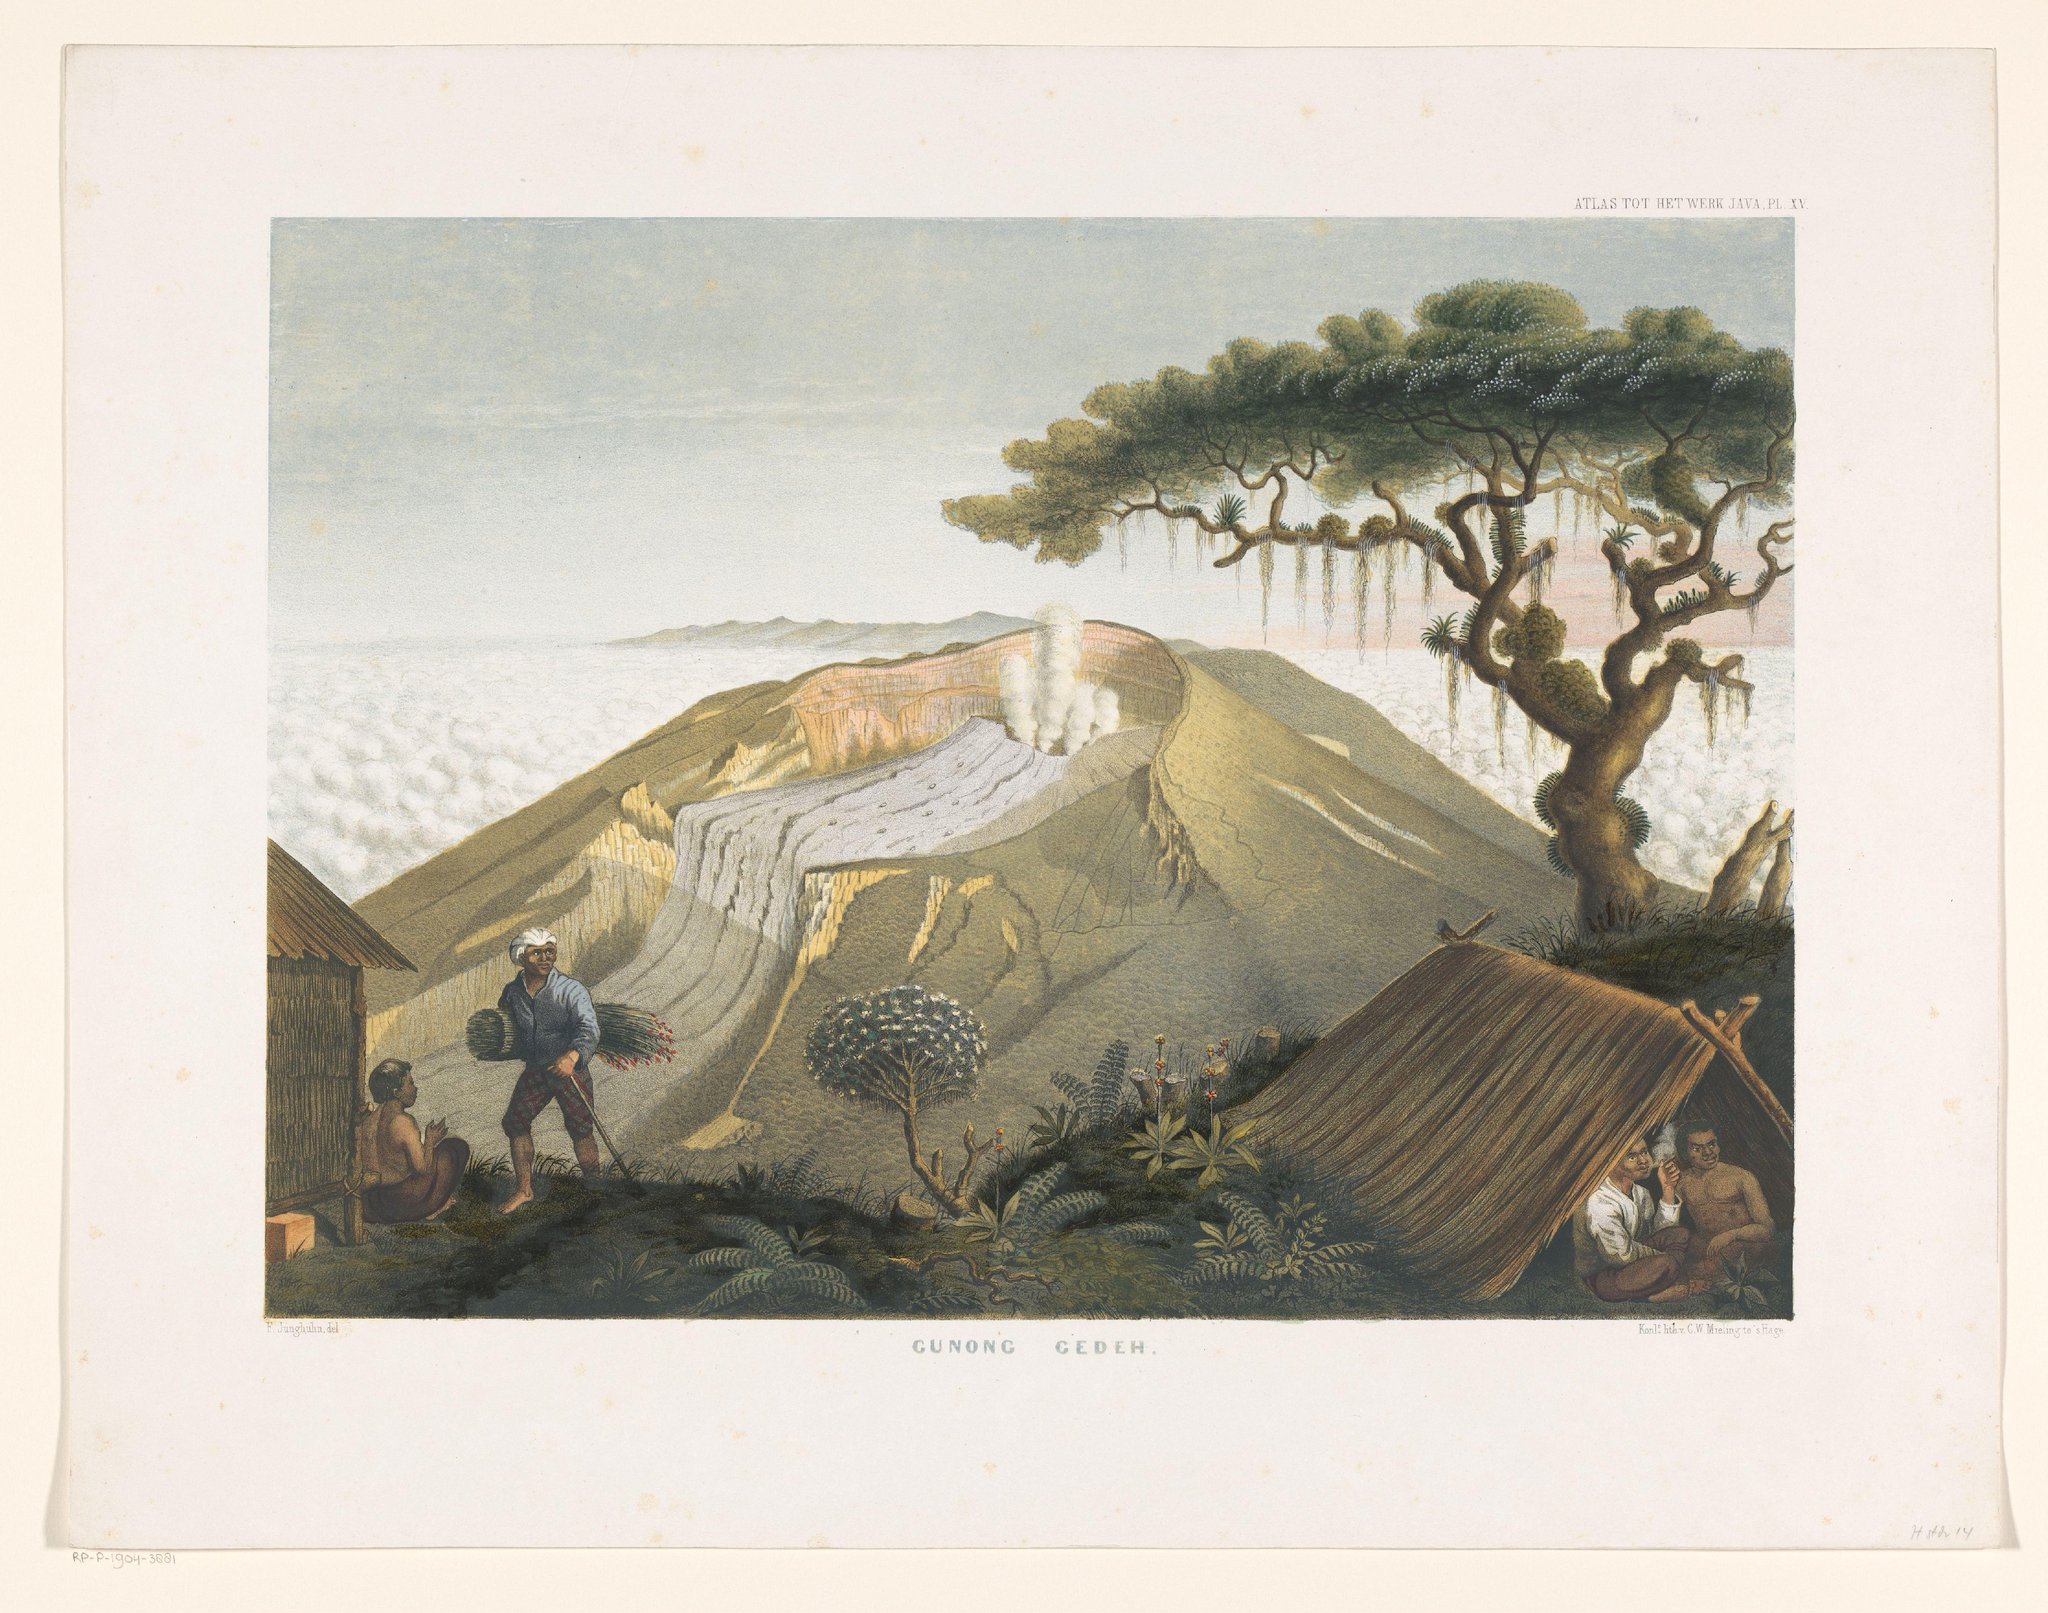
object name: print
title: Vulkaan Gede te West-Java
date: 1854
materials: paper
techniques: lithograph, hand coloring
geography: the hague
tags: volcano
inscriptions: collector's mark: Lugt 2228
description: Onderdeel van een serie van elf, bedoeld als aanvulling op: Junghuhn, Franz. Java: zijne gedaante, zijn plantentooi en inwendige bouw. 4 delen. Den Haag: Carl Wilheml Mieling, 1853-1854. Zie ook RP-P-1904-3877 (ander kleurenpalet).